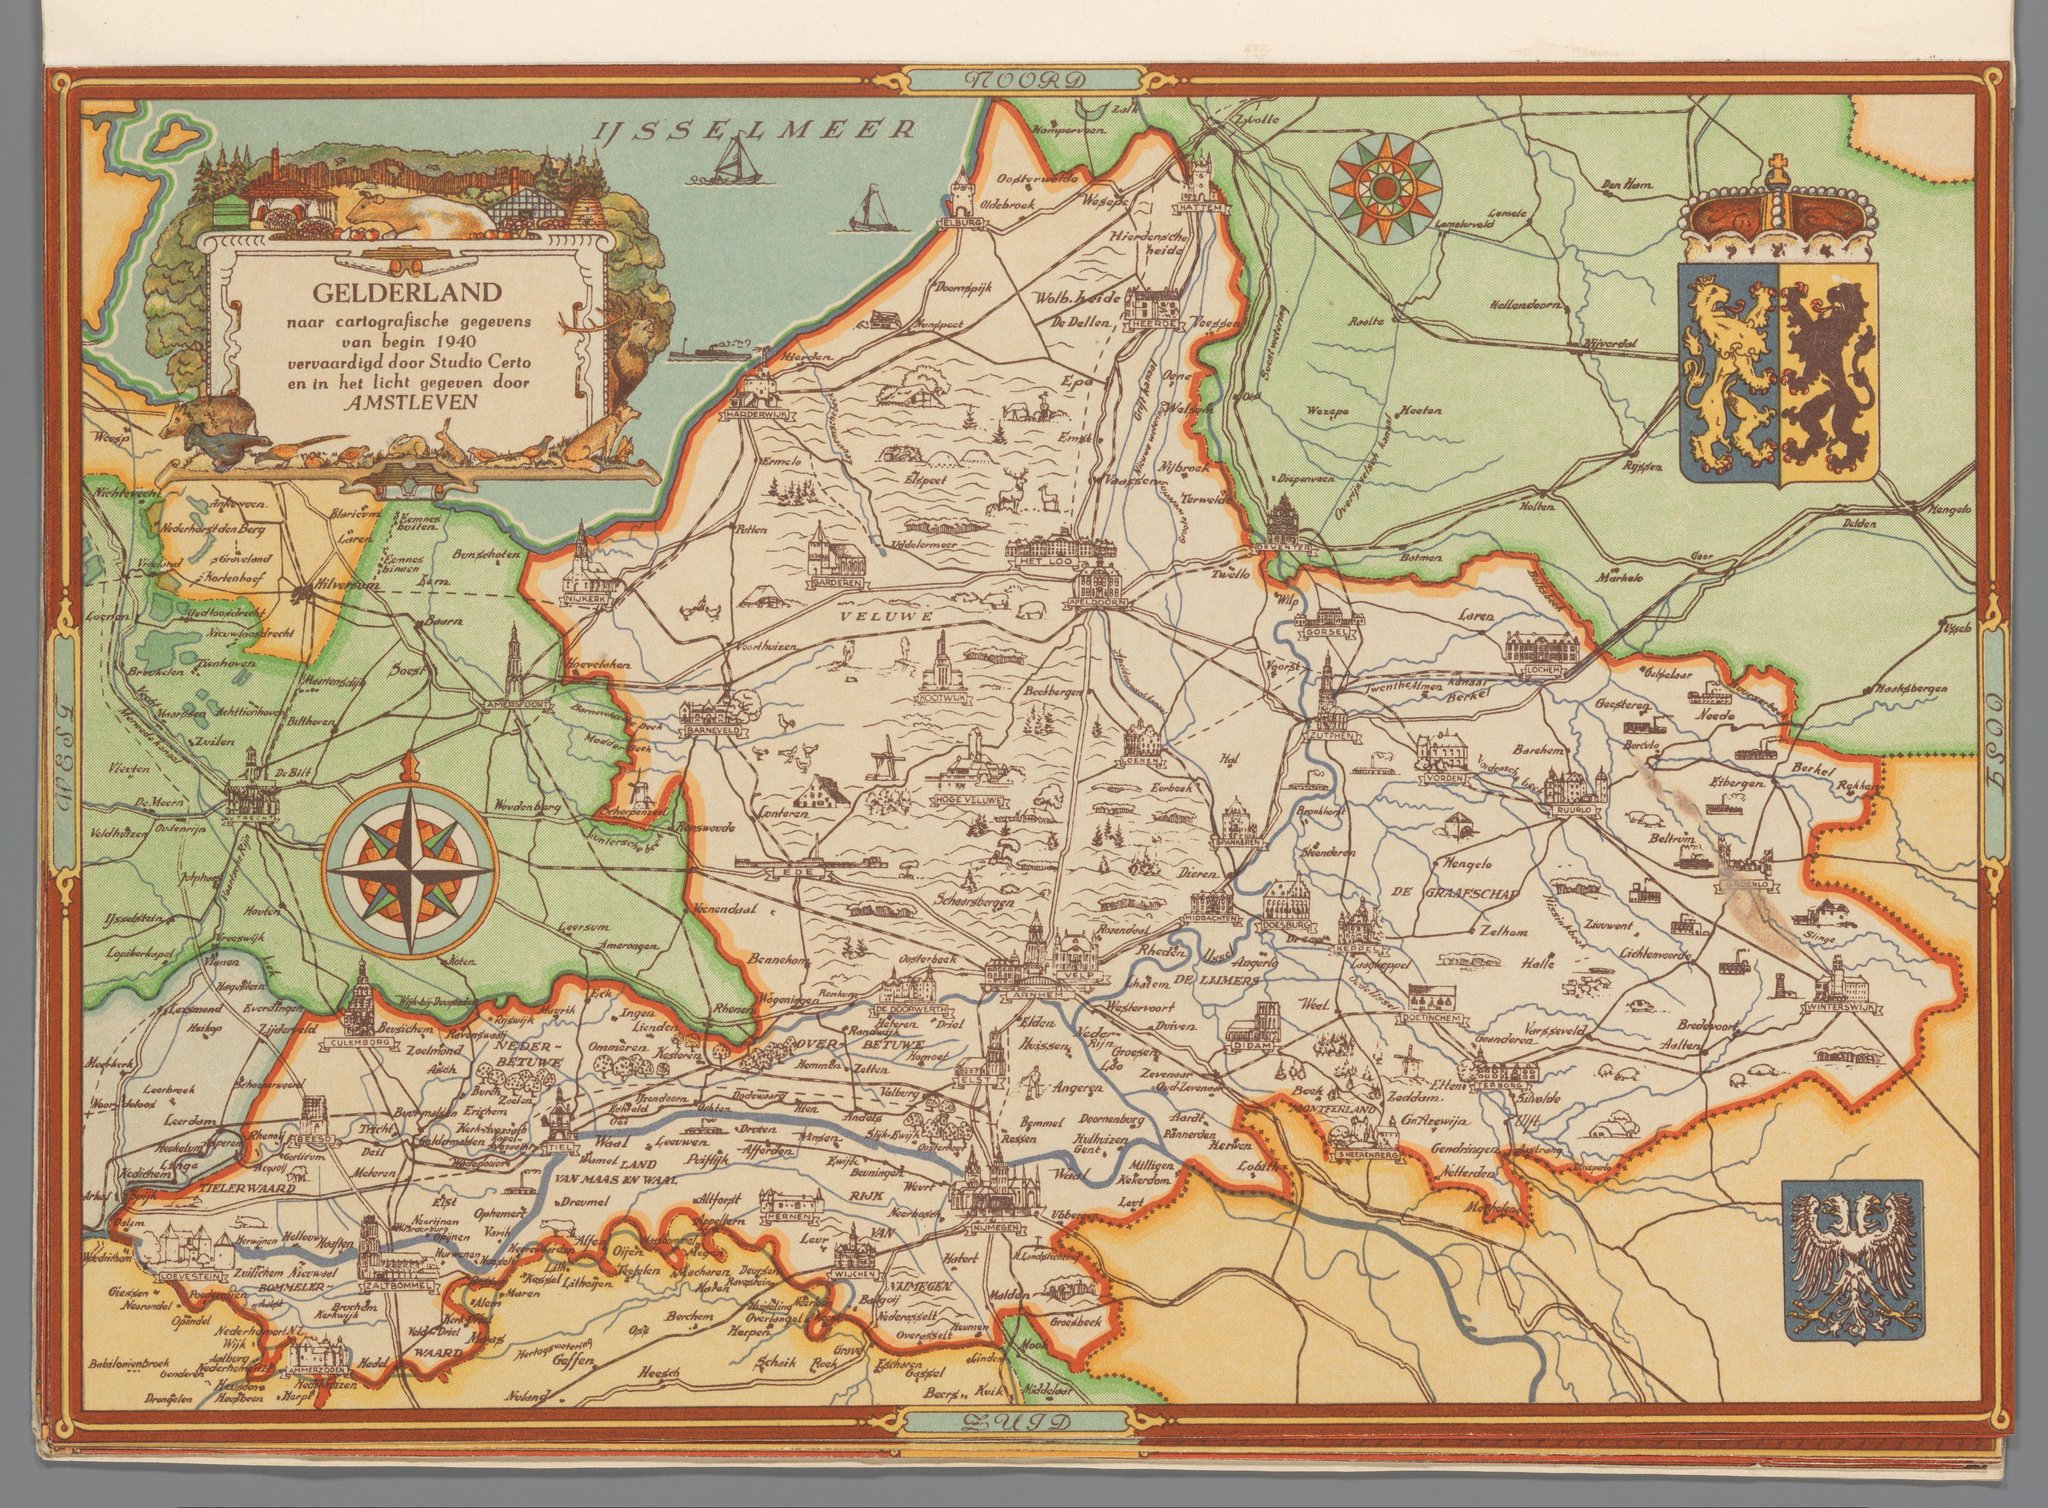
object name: book illustration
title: Gelderland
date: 1947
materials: paper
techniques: lithograph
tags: maps, atlases, gelderland